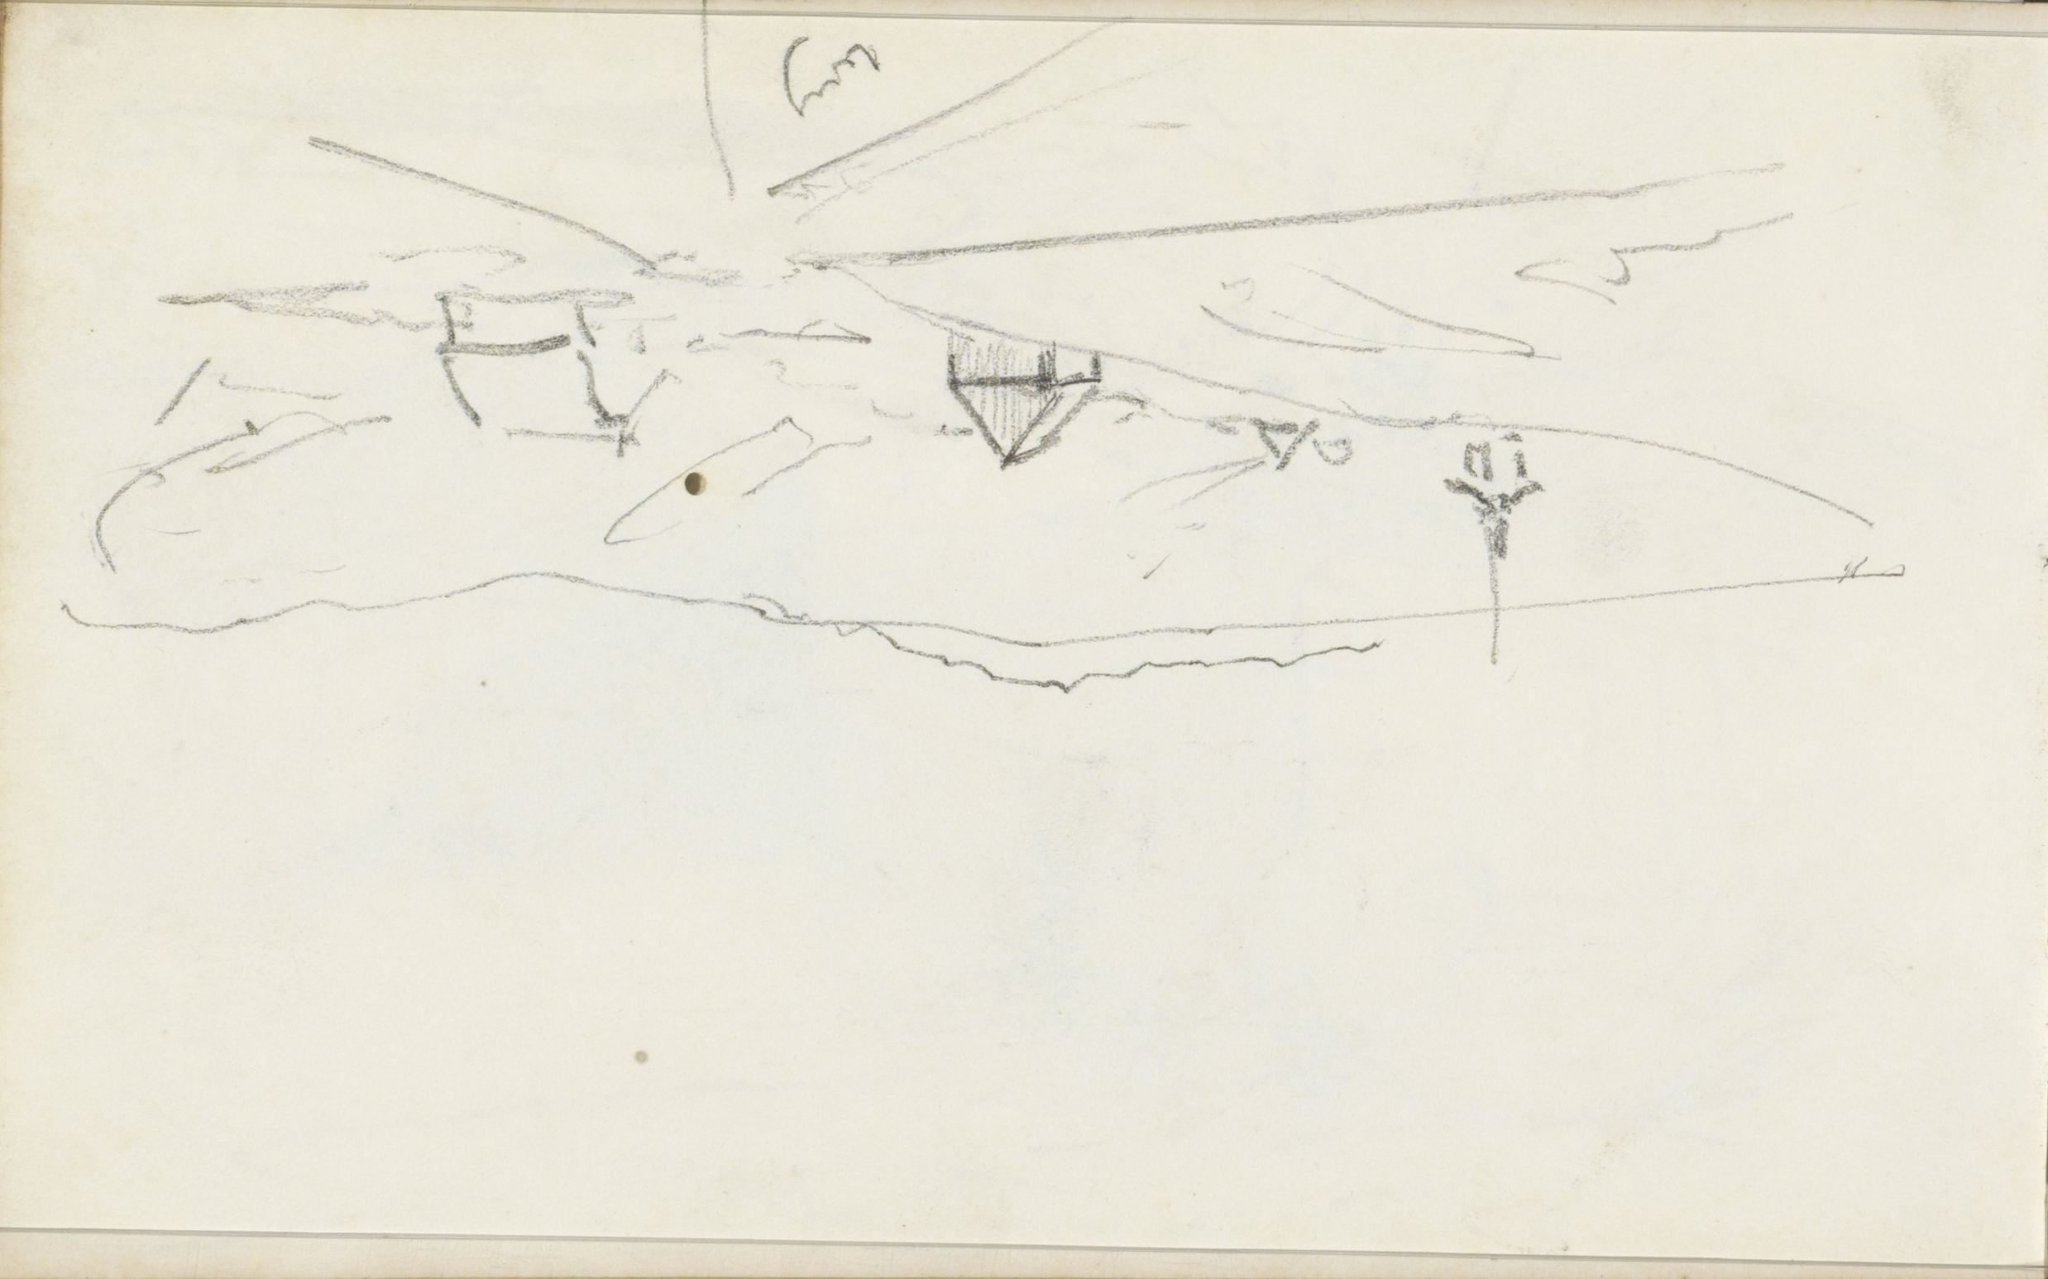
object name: sketchbook leaf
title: Heuvellandschap met huizen en een kerk aan een weg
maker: johannes tavenraat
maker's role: draughtsman, painter, print maker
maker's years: 1809-1881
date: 1840-1841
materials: paper, pencil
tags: city-view, and landscape with man-made constructions, road, path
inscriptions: annotation: ‘weg’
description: Blad 20 verso uit een schetsboek met 41 bladen.